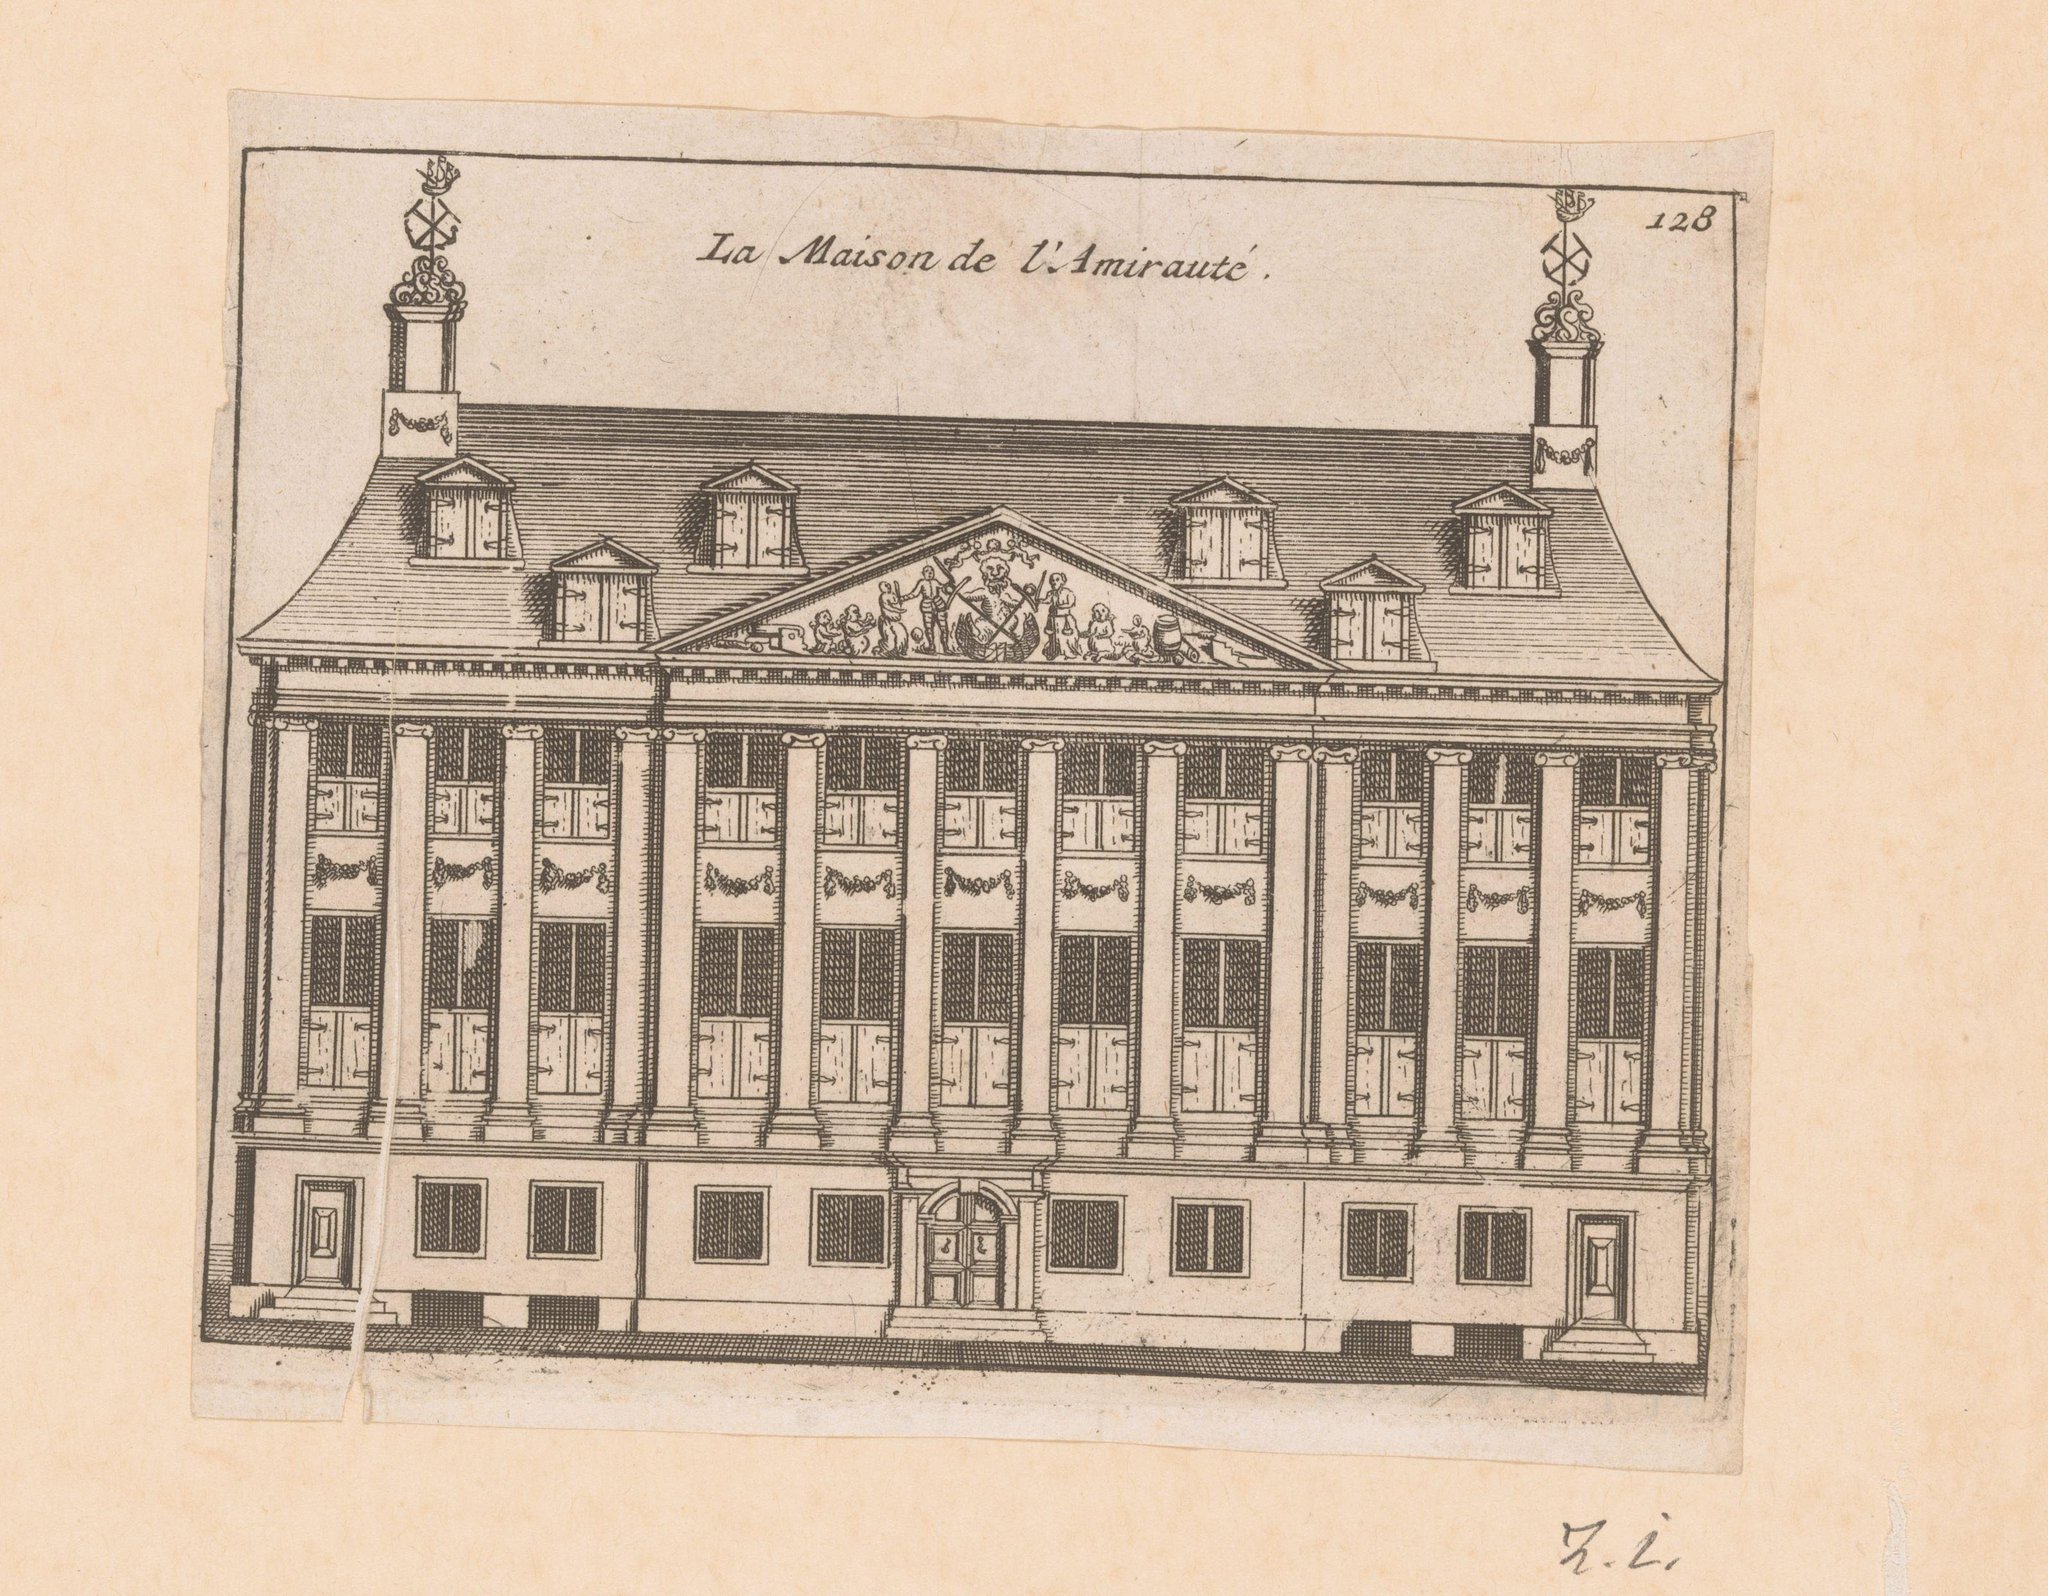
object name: print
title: Voorgevel van het Admiraliteitshuis in Amsterdam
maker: Anonymous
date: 1685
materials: paper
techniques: etching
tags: exterior ~ representation of a building, civic architecture; edifices; dwellings, amsterdam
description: Prent verschenen in: Domselaar, Tobias van. Beschryvinge van Amsterdam, haar eerste oorspronk uyt den Huyze der Heeren van Aemstel en Aemstellant; met een verhaal van haar leven en dappere krijgsdaden (...). Amsterdam: Marcus Willemsz. Doornick, 1685.